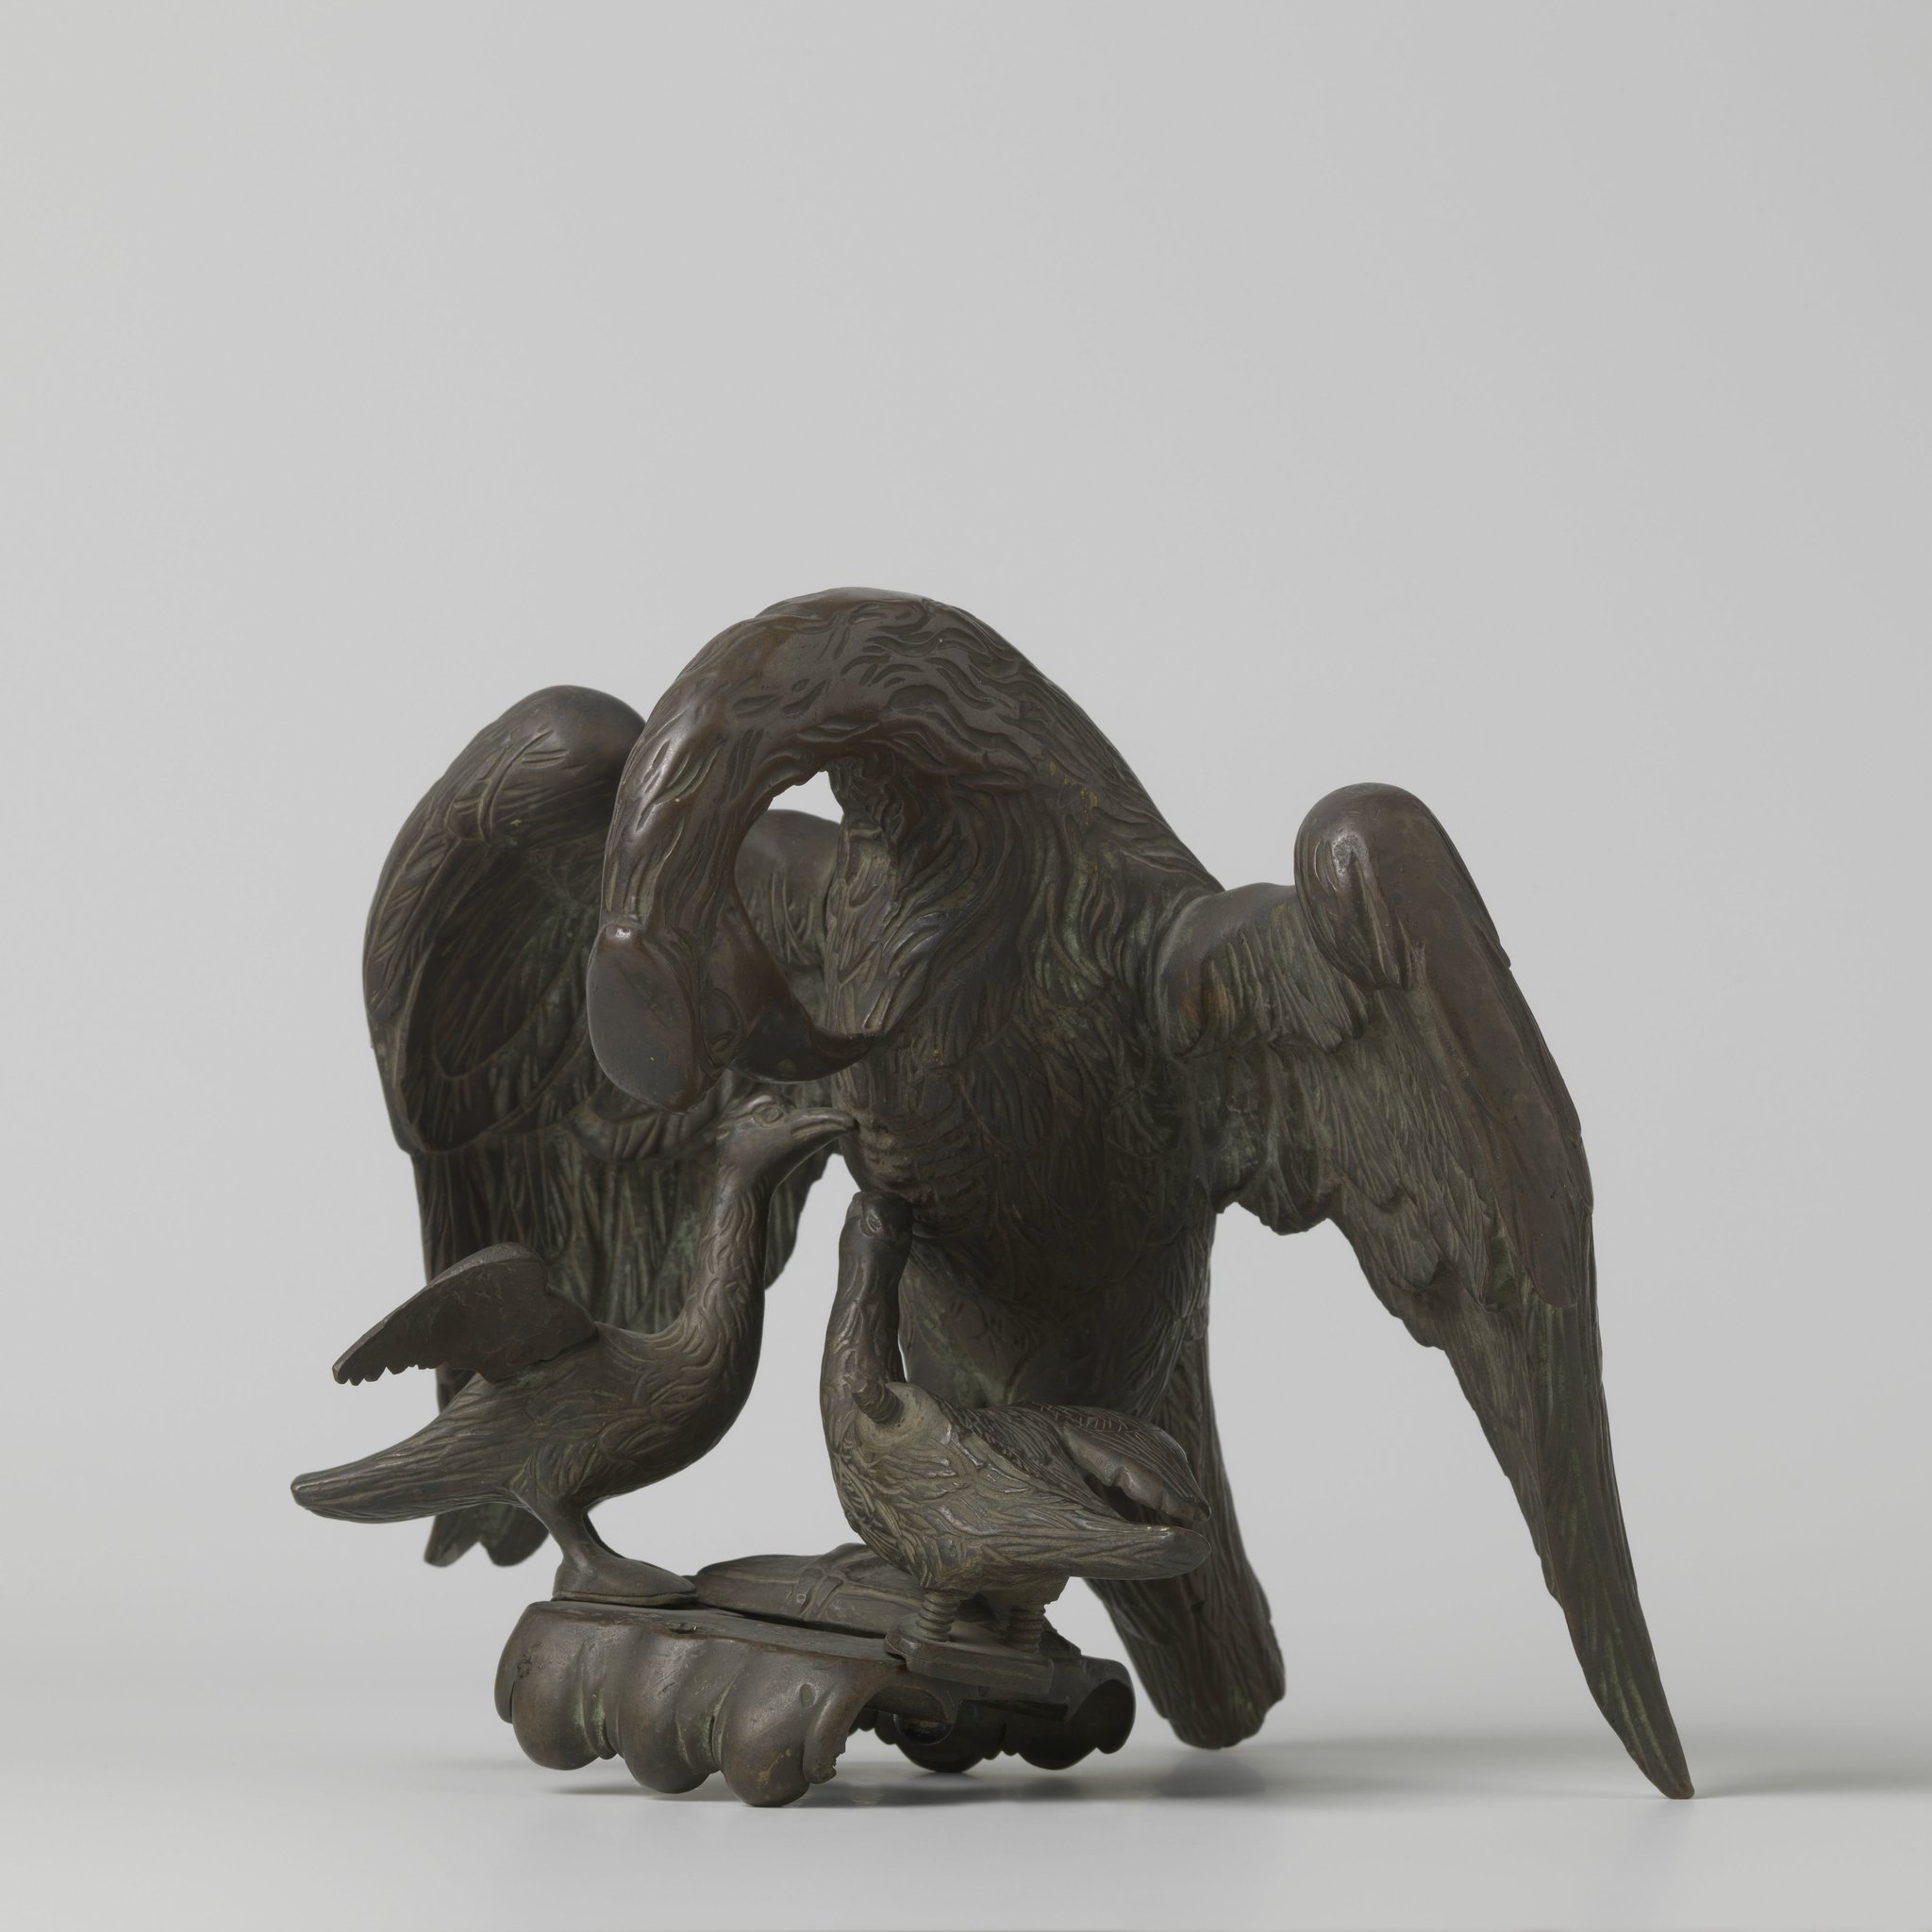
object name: figure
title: Pelikaan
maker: Anonymous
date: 1750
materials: brass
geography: netherlands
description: Het voowerp is samengesteld uit de volgende gegoten en gegraveerde onderdelen: het voetstuk, de twee vleugels, de twee jongen. Het voetstuk is aan voor- en achterkant geornamenteerd. De pelikaan houdt zijn vleugels gespreid en pikt zich in de borst. De jongen die eveneens met de vleugels klapwieken, houden hun kop naar de borst van de pelikaan gericht. Beeld van een pelikaan. Betreft een groep van pelikaan met twee jongen, zie ook BK-NM-9443-b en c. De groep symboliseert het Christelijk geloof.